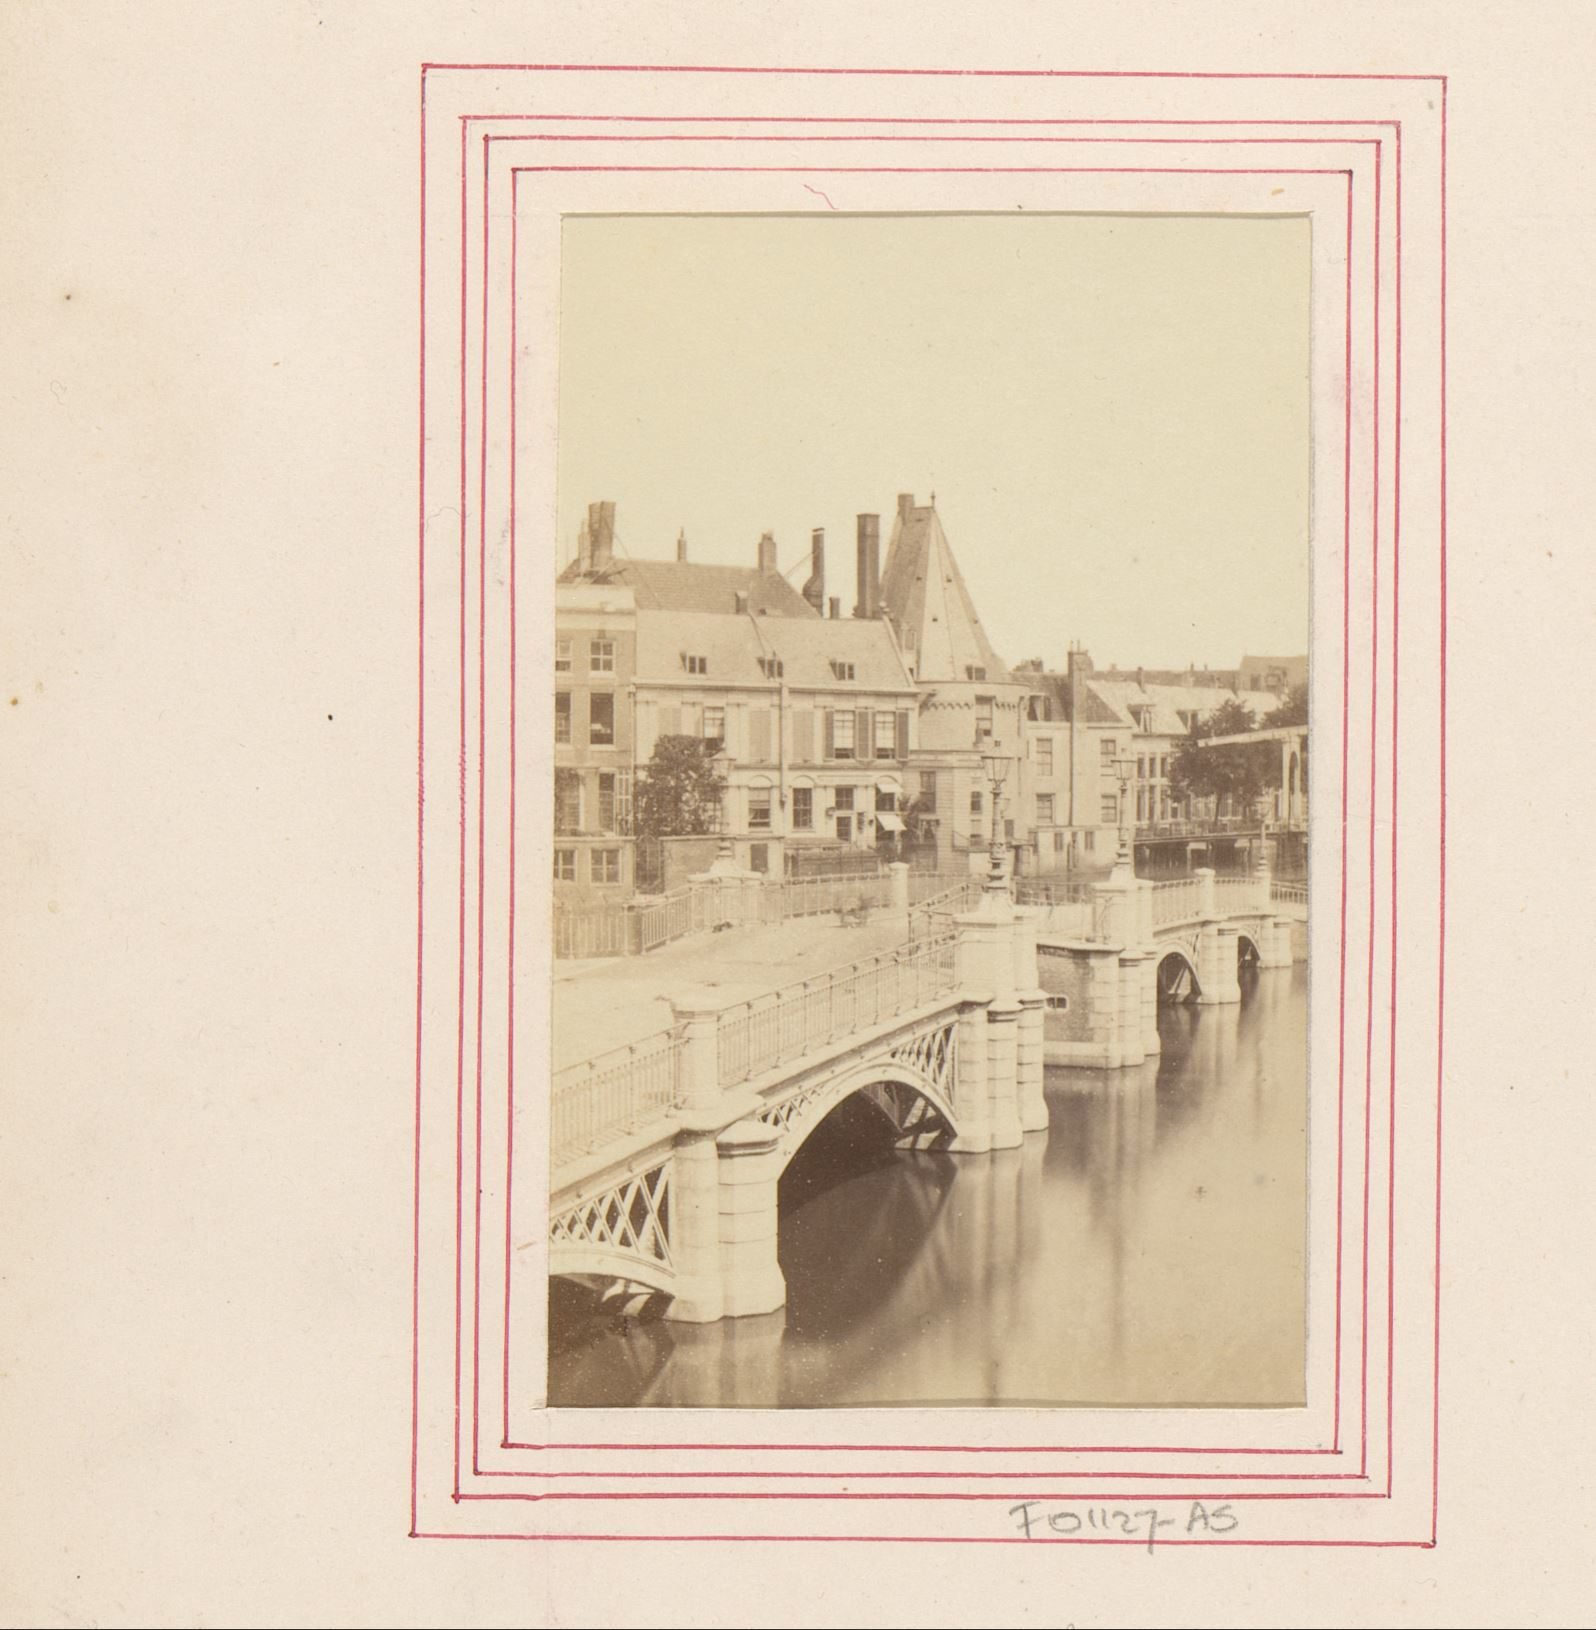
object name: photograph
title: Halvemaansbrug over de Amstel en toren Swygh Utrecht in Amsterdam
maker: pieter oosterhuis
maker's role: draughtsman, print maker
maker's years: 1816-1885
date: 1863-1870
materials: photographic support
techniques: albumen print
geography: amsterdam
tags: towers ~ fortified city, bridge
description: Onderdeel van Album met foto's en litho's van bezienswaardigheden in Noord- en Zuid-Hollandse steden, schilderijen en klederdrachten.